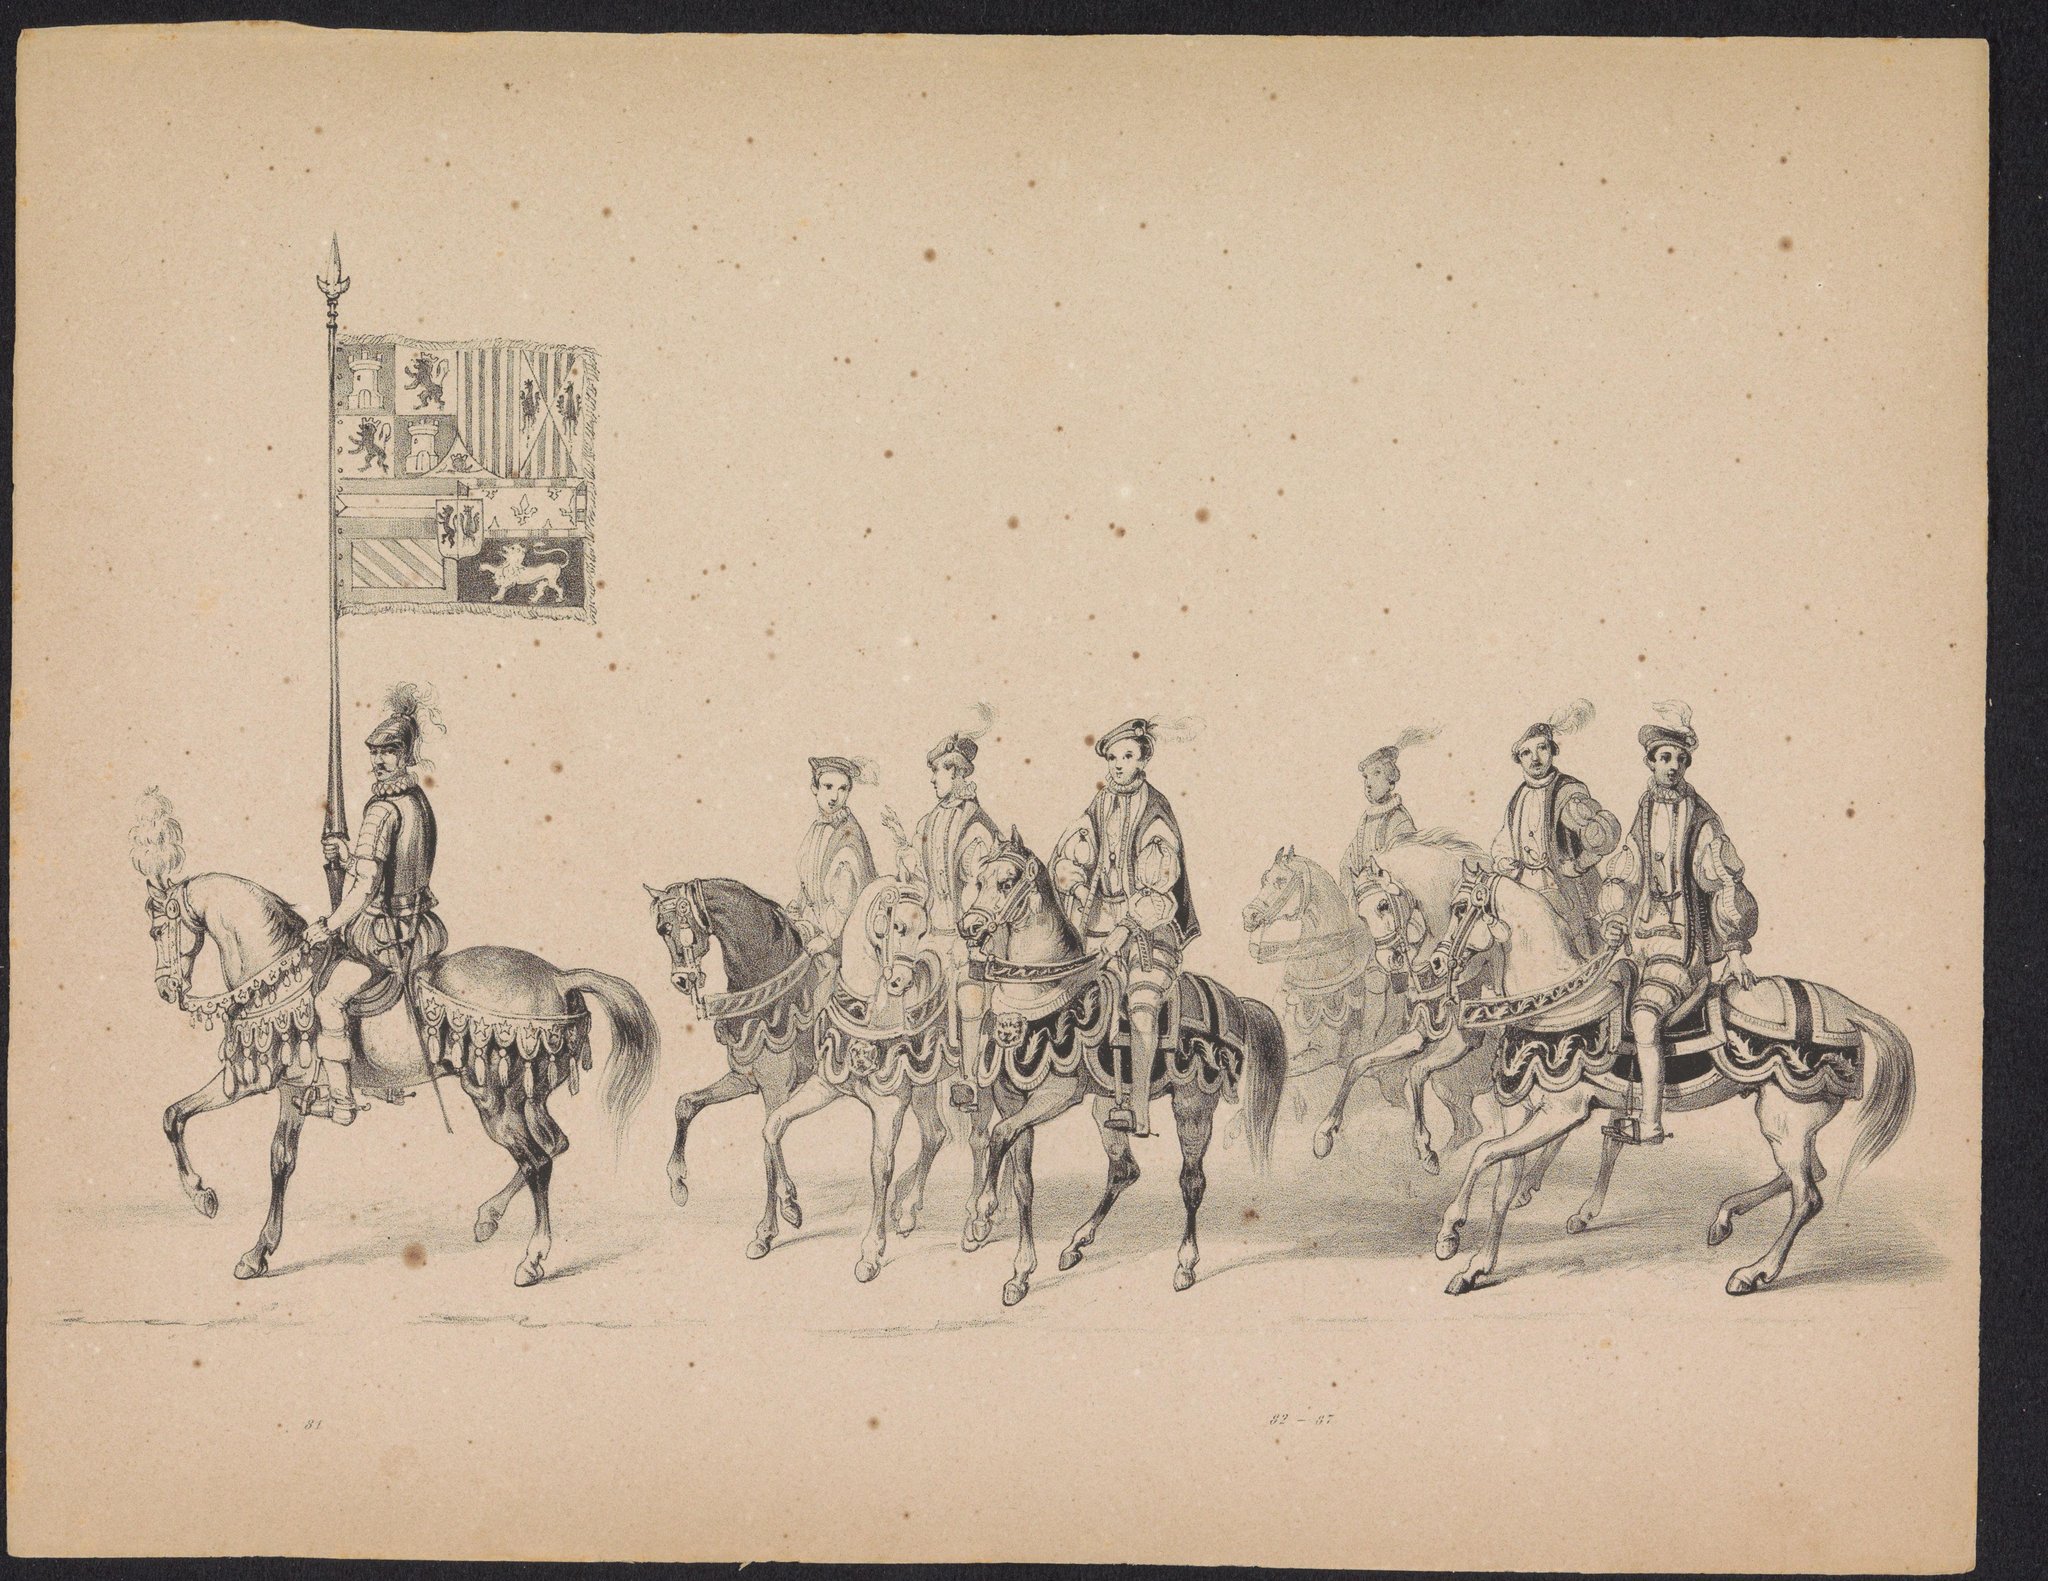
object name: print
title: Maskerade van de Utrechtse studenten, 1846 (plaat 15)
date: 1847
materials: paper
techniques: lithograph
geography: netherlands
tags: philip ii of spain, students' pageant, costumes used in pageants, utrecht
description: Historische gekostumeerde optocht van de studenten van de Utrechtse Hogeschool gehouden op 17 juni 1846 ter gelegenheid van het 210-jarig bestaan van de Hogeschool. De optocht verbeeldt de intocht van Filips II in Utrecht op 3 oktober 1549. Plaat met de groepen genummerd 81-87. Onderdeel van de serie van 22 aanelkaar te plakken losse bladen.